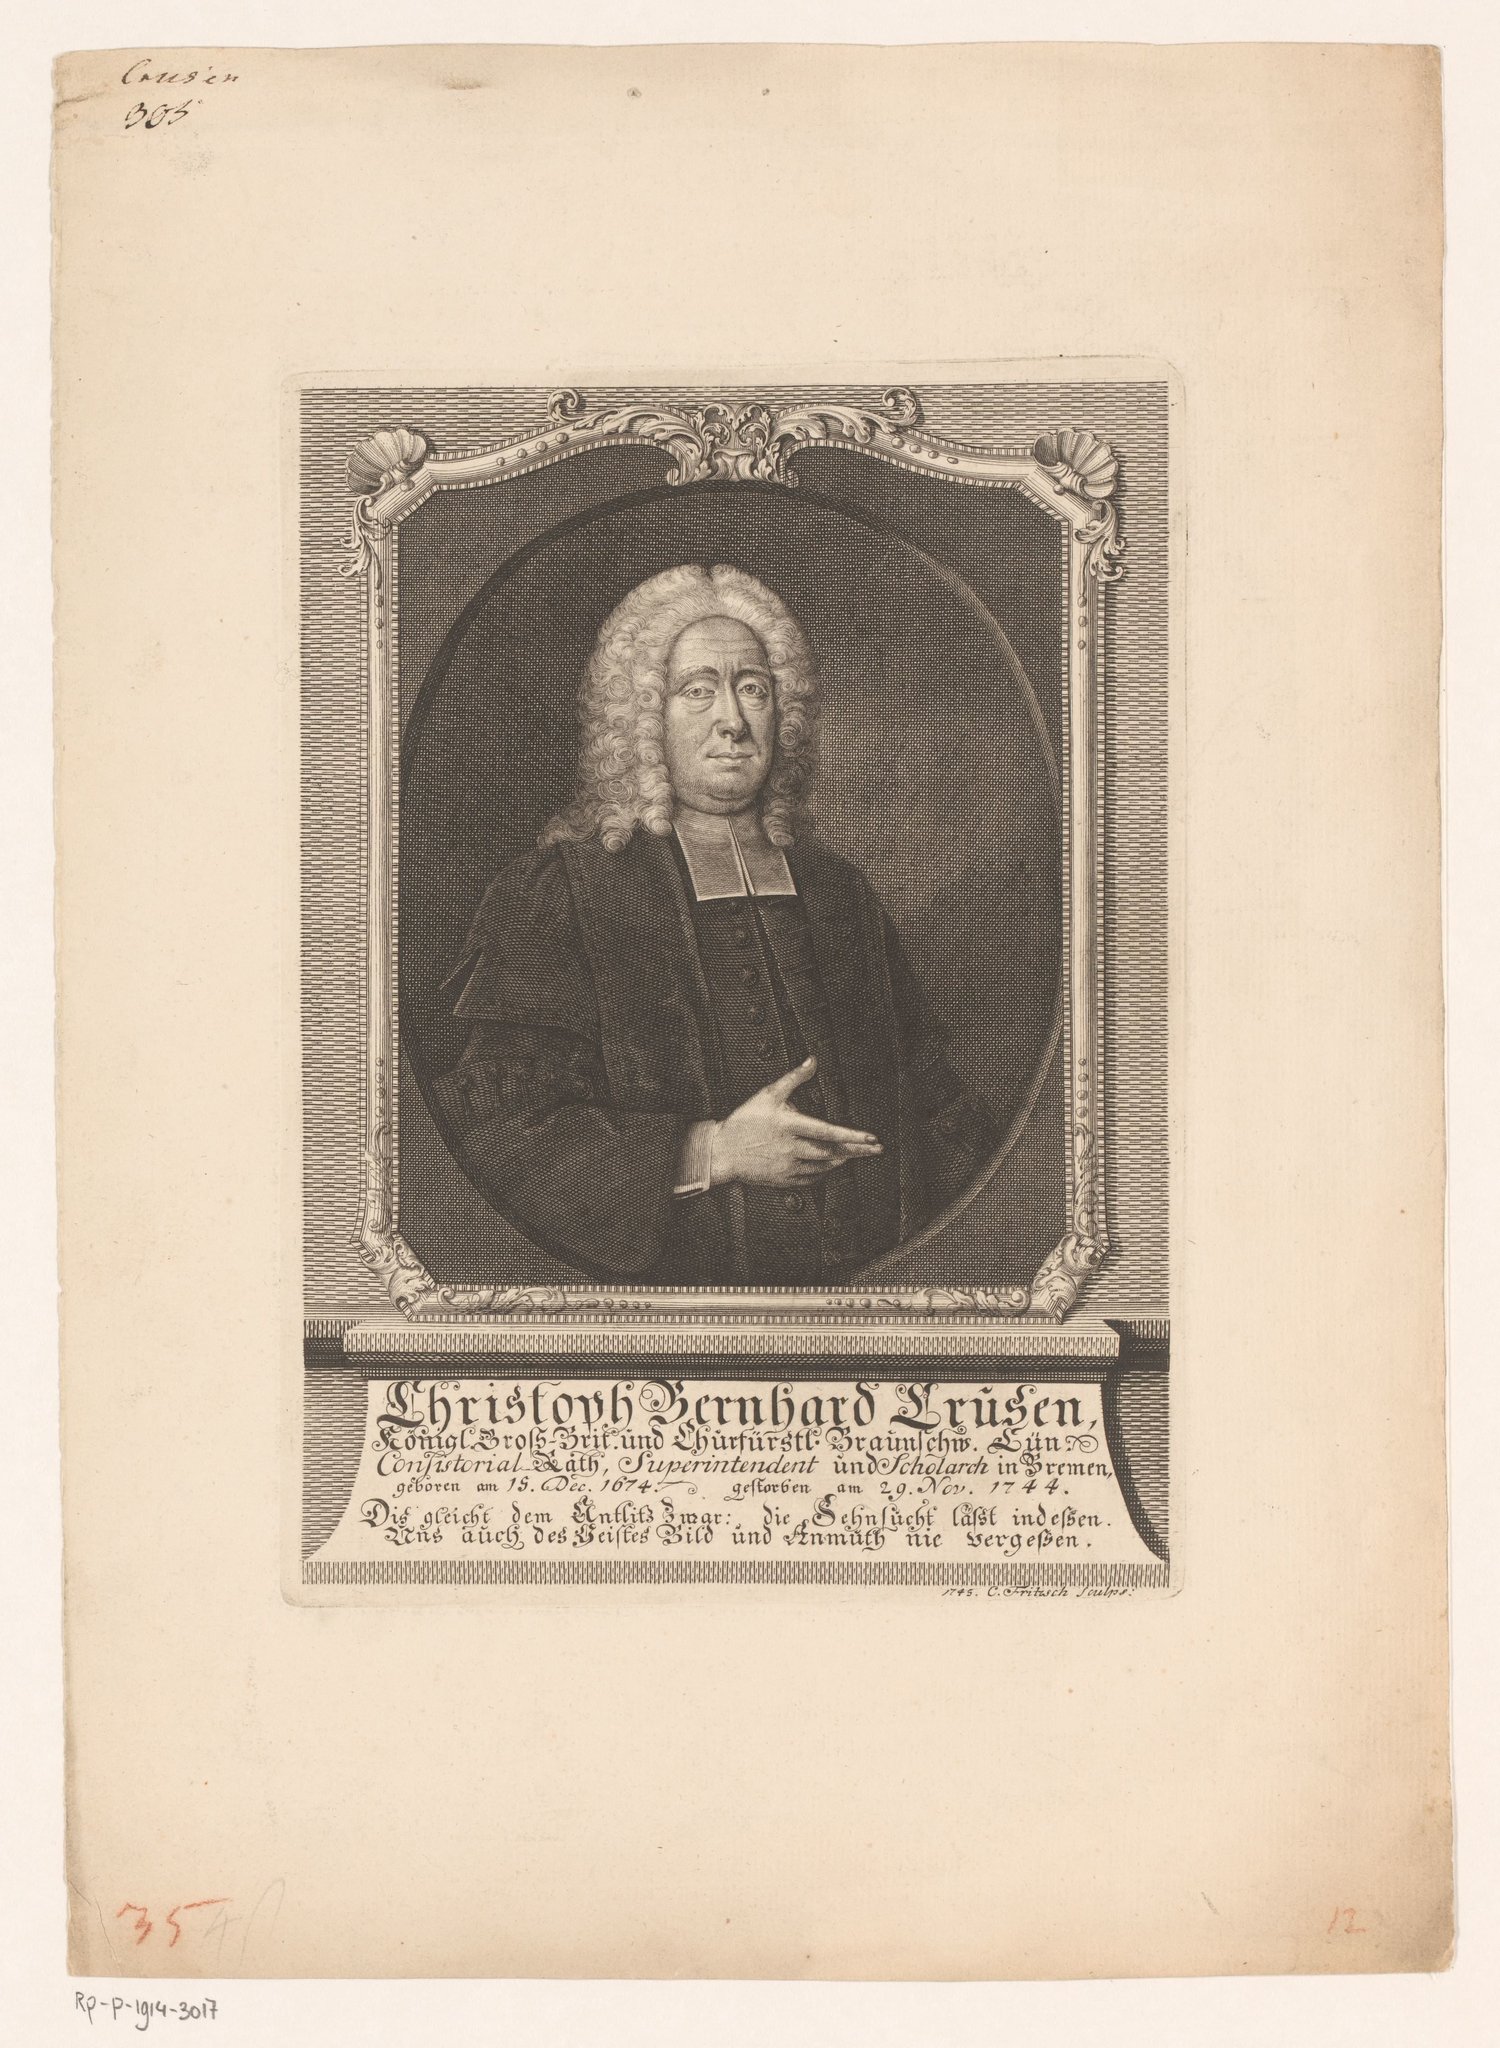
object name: print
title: Portret van Christoph Bernhard Cruse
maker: christian fritzsch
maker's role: print maker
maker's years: 1695-1769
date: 1745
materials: paper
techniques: engraving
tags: historical persons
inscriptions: collector's mark: Lugt 2228